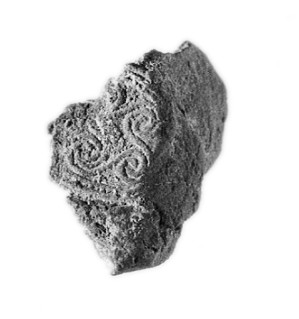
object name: sealing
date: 1981-1640 BCE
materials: mud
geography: egypt